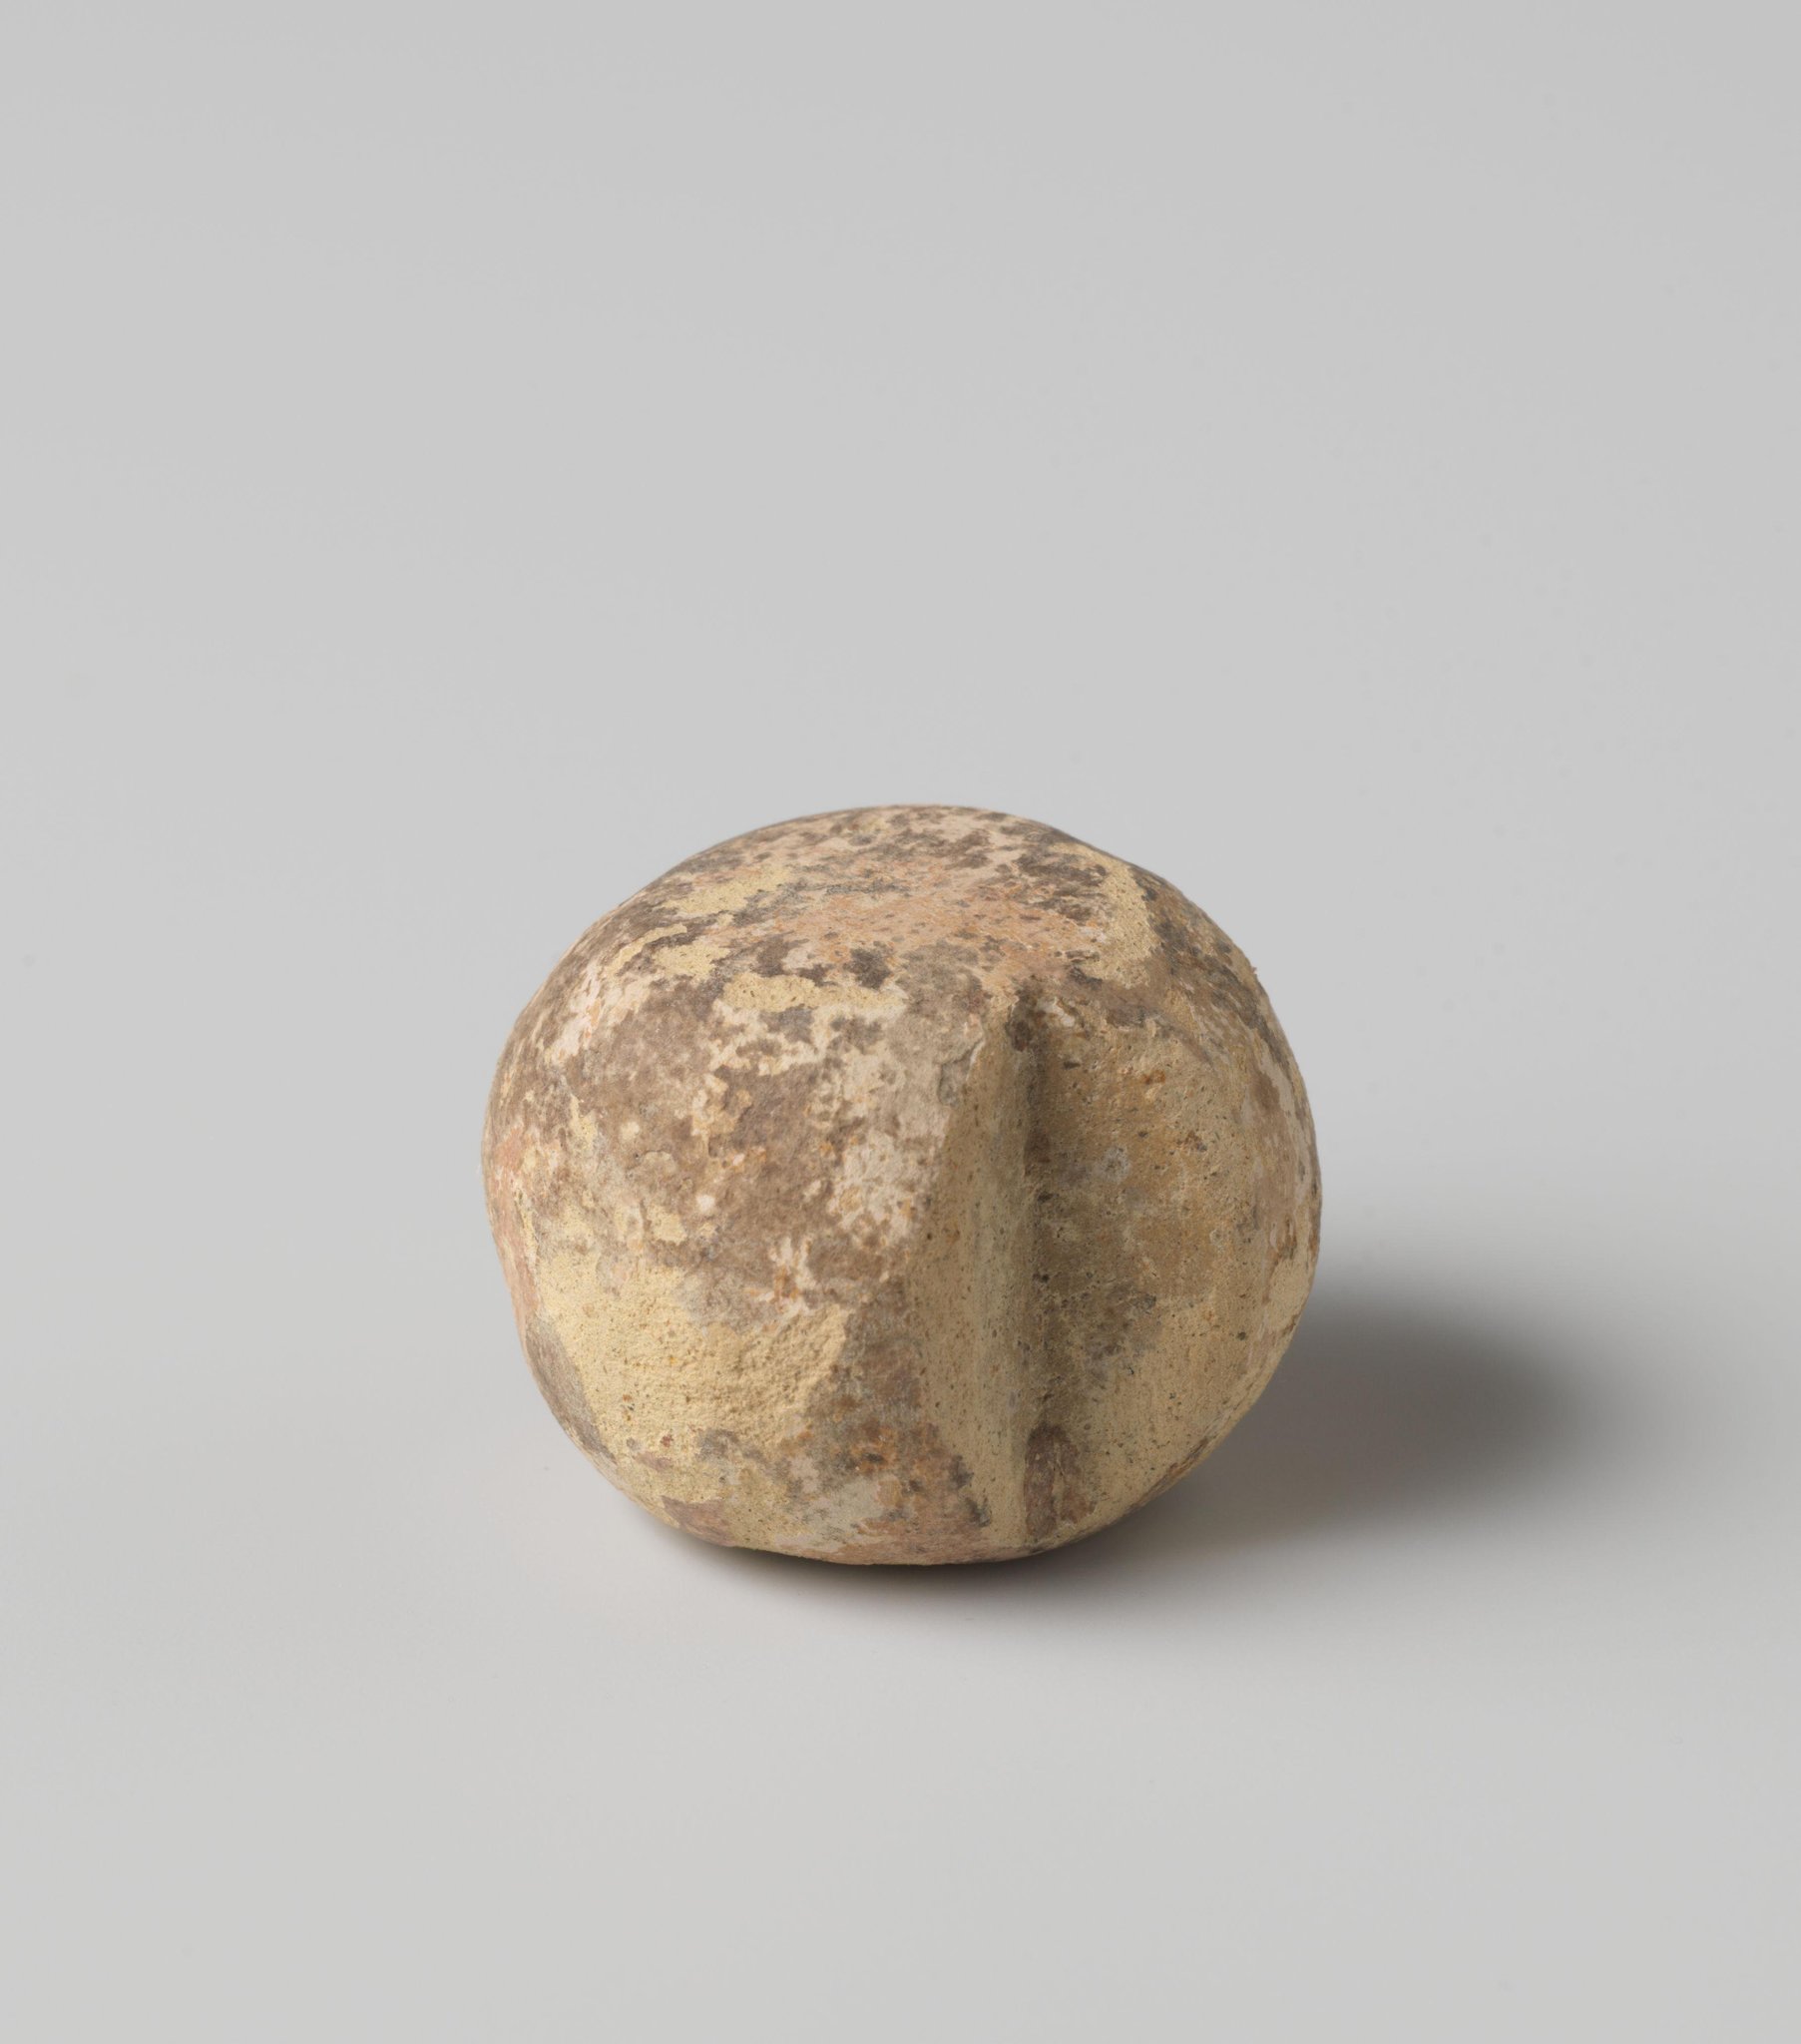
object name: miniature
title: Kaas, rond, waaruit een punt is gesneden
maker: Anonymous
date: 1700-1799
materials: clay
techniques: painted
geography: netherlands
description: Ronde kaas met stuk eruit, van klei substantie, resten van geelbruin beschildering.